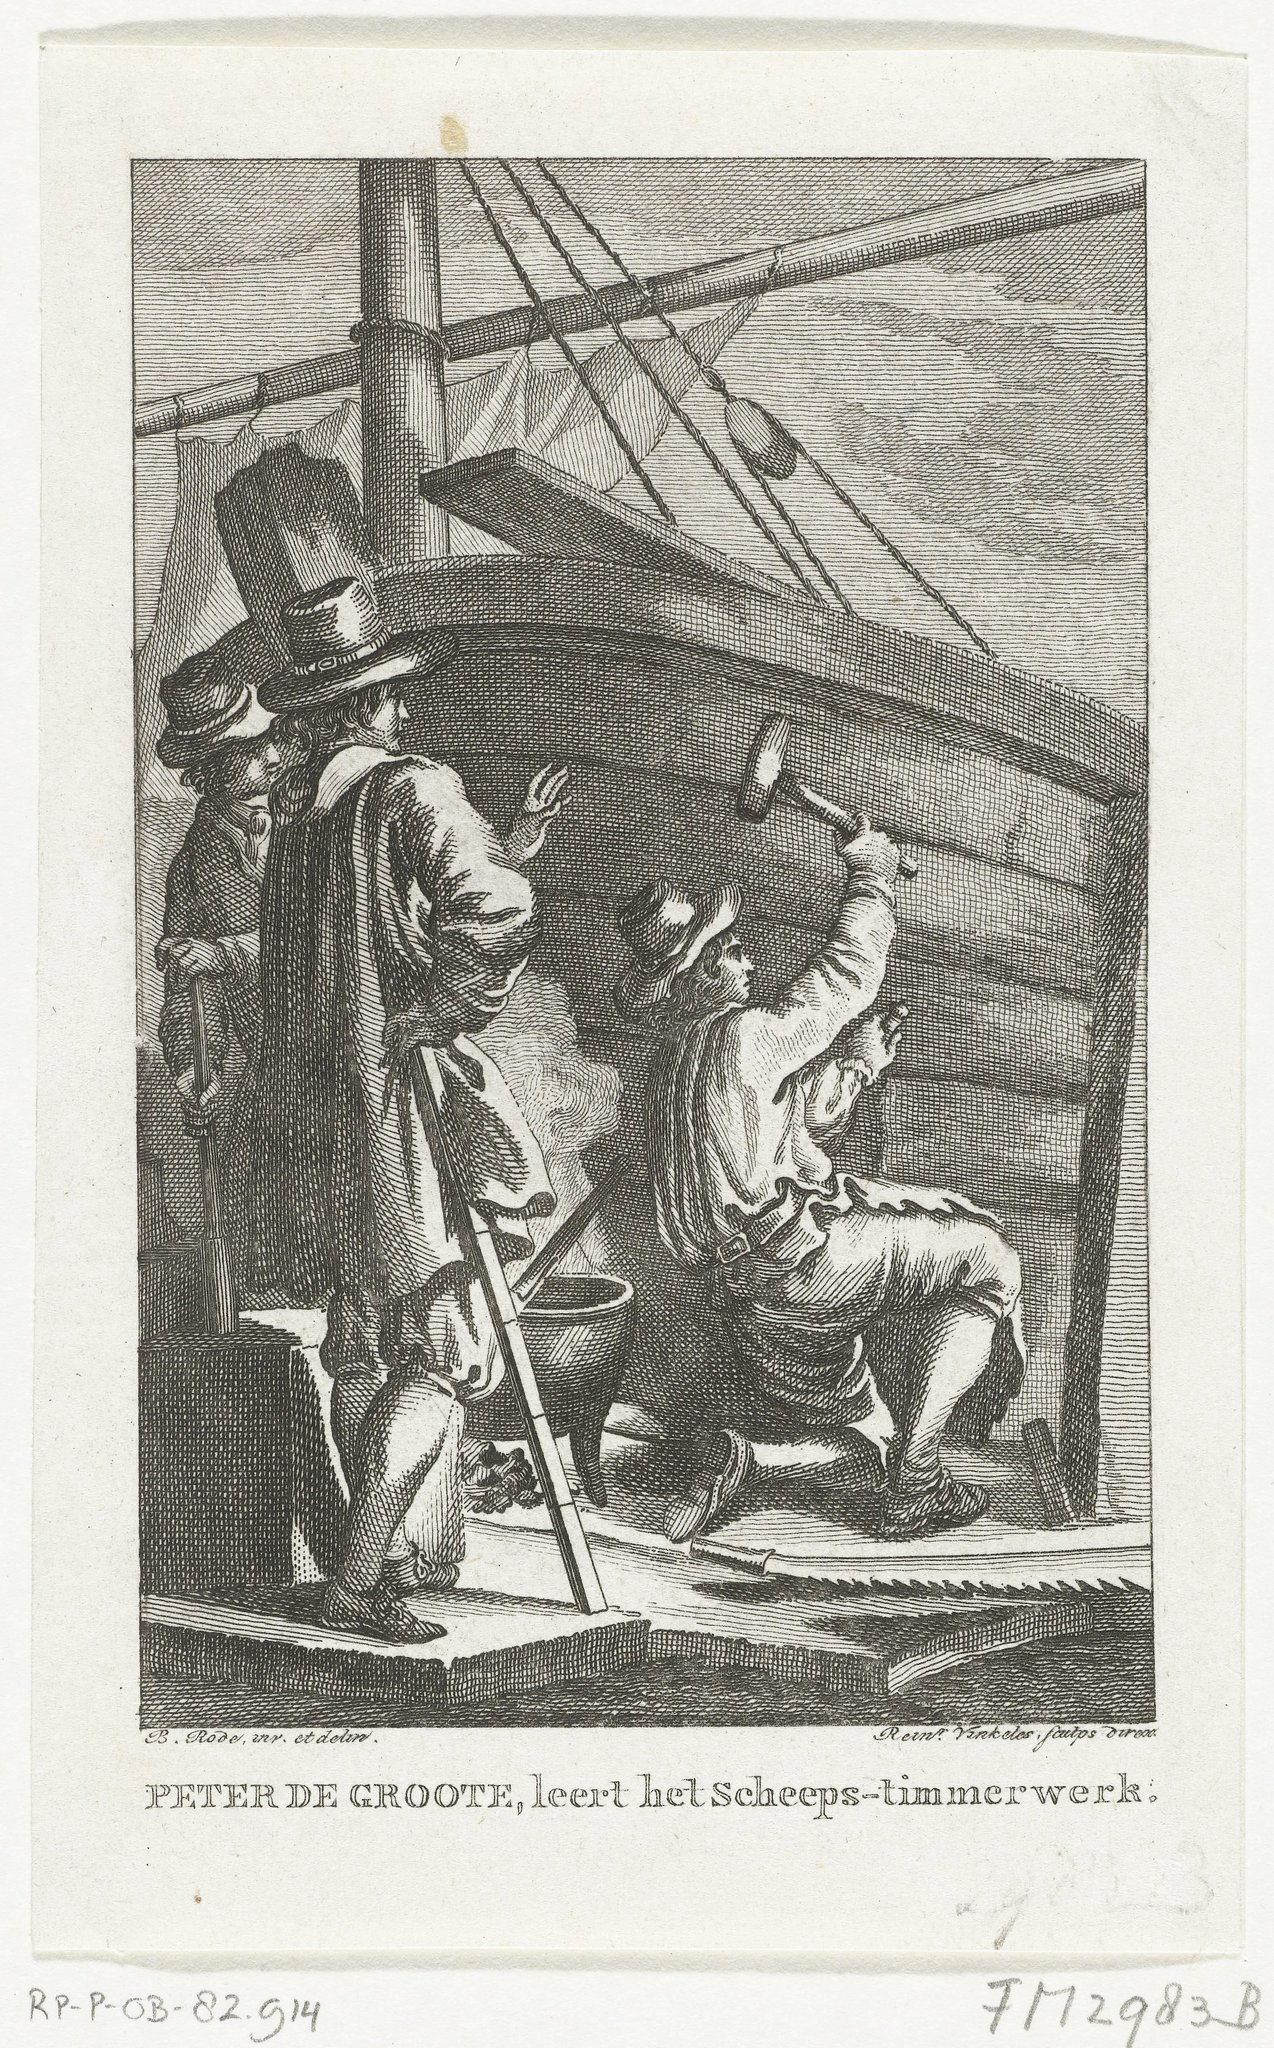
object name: history print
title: Tsaar Peter de Grote werkend op de werf te Amsterdam, 1697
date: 1751-1797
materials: paper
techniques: etching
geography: northern netherlands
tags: peter i de grote (tsaar van rusland), shipyard-workers, amsterdam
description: Waarschijnlijk gebruikt als illustratie in Y. van Hamelsveld, Kort begrip der algemeene geschiedenis, van de schepping der wereld af, tot het einde der agttiende eeuw, Johannes Allart, Amsterdam 1802. Niet in Frederik Muller; door het RPK toegevoegd nummer.